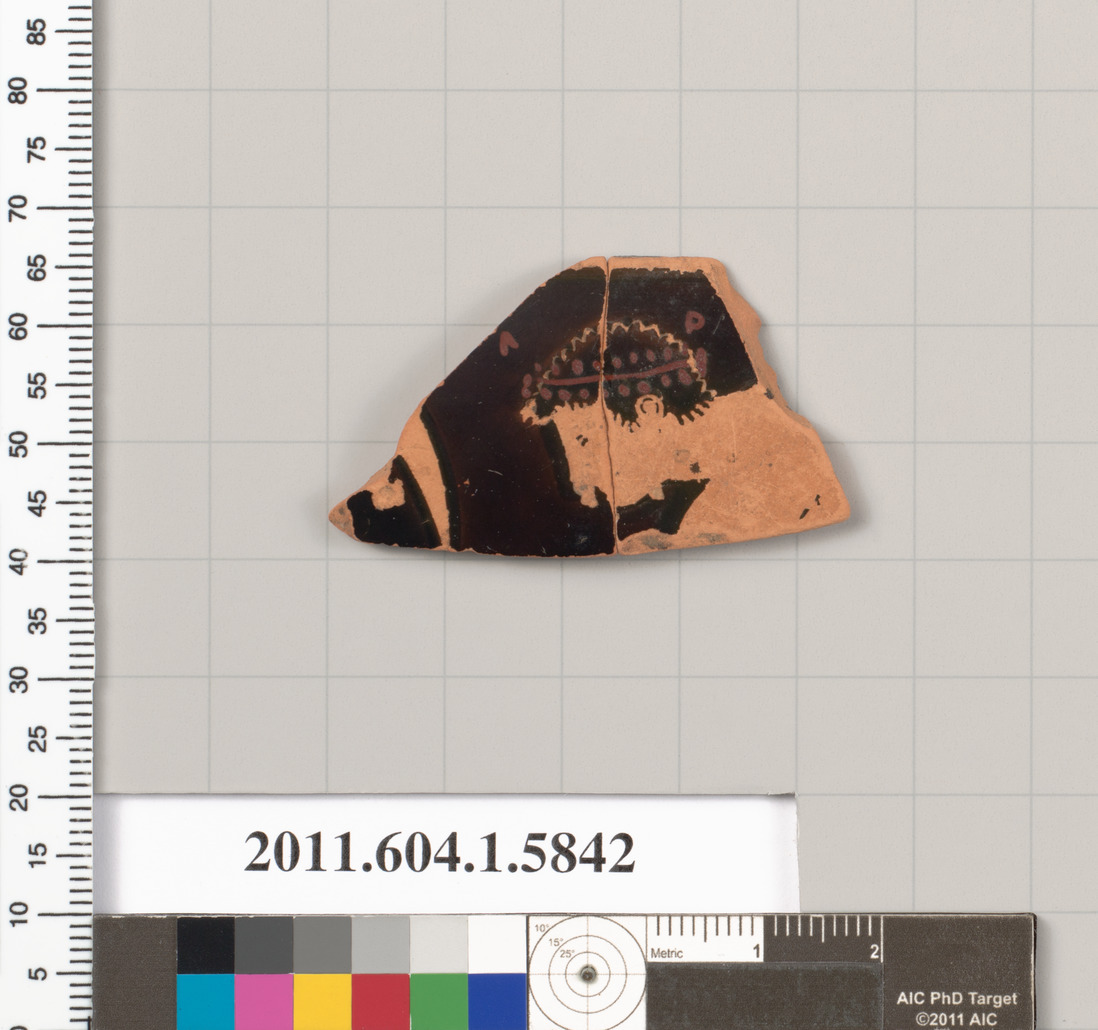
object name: kylix fragment, eye cup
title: Terracotta rim fragment of a kylix: eye-cup (drinking cup)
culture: greek, attic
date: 433-567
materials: terracotta